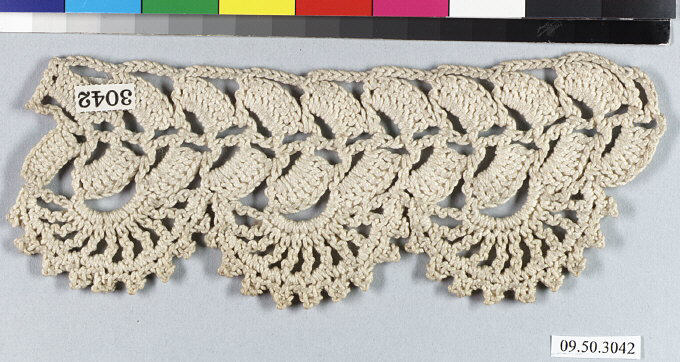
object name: sample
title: Crochet Work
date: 1801-1900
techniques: crochet